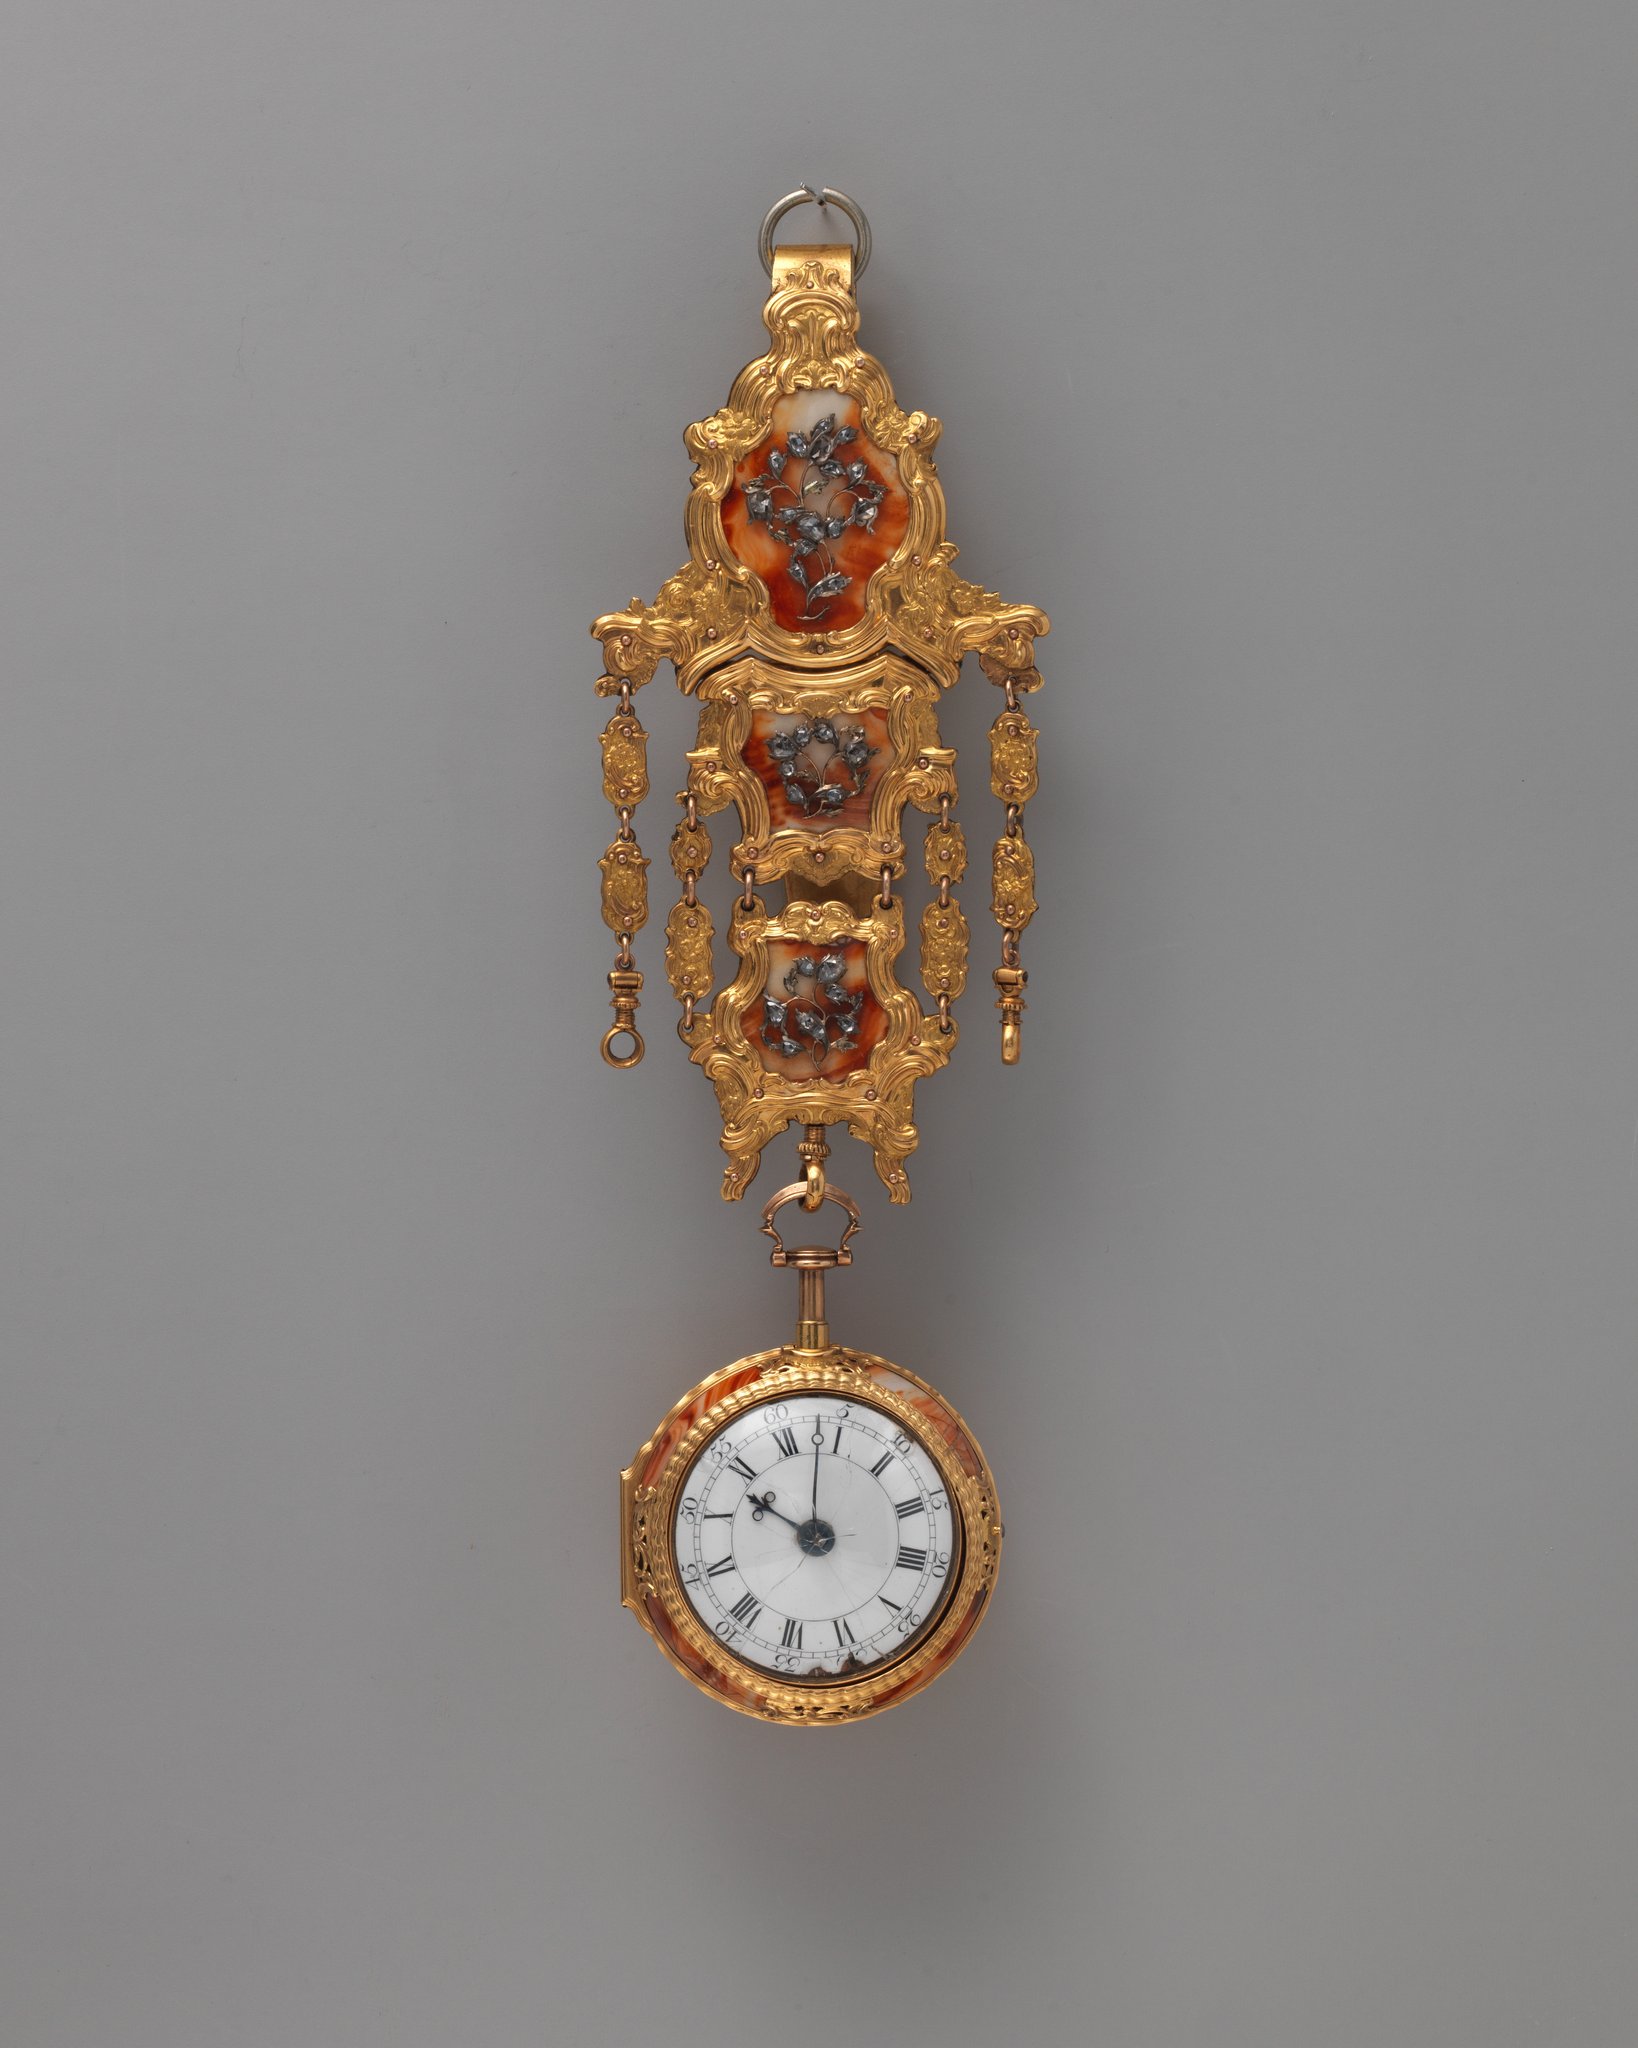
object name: watch and chatelaine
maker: francis perigal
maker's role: maker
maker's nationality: british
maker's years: 1741-1767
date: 1701-1800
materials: diamond, enamel, gold, silver